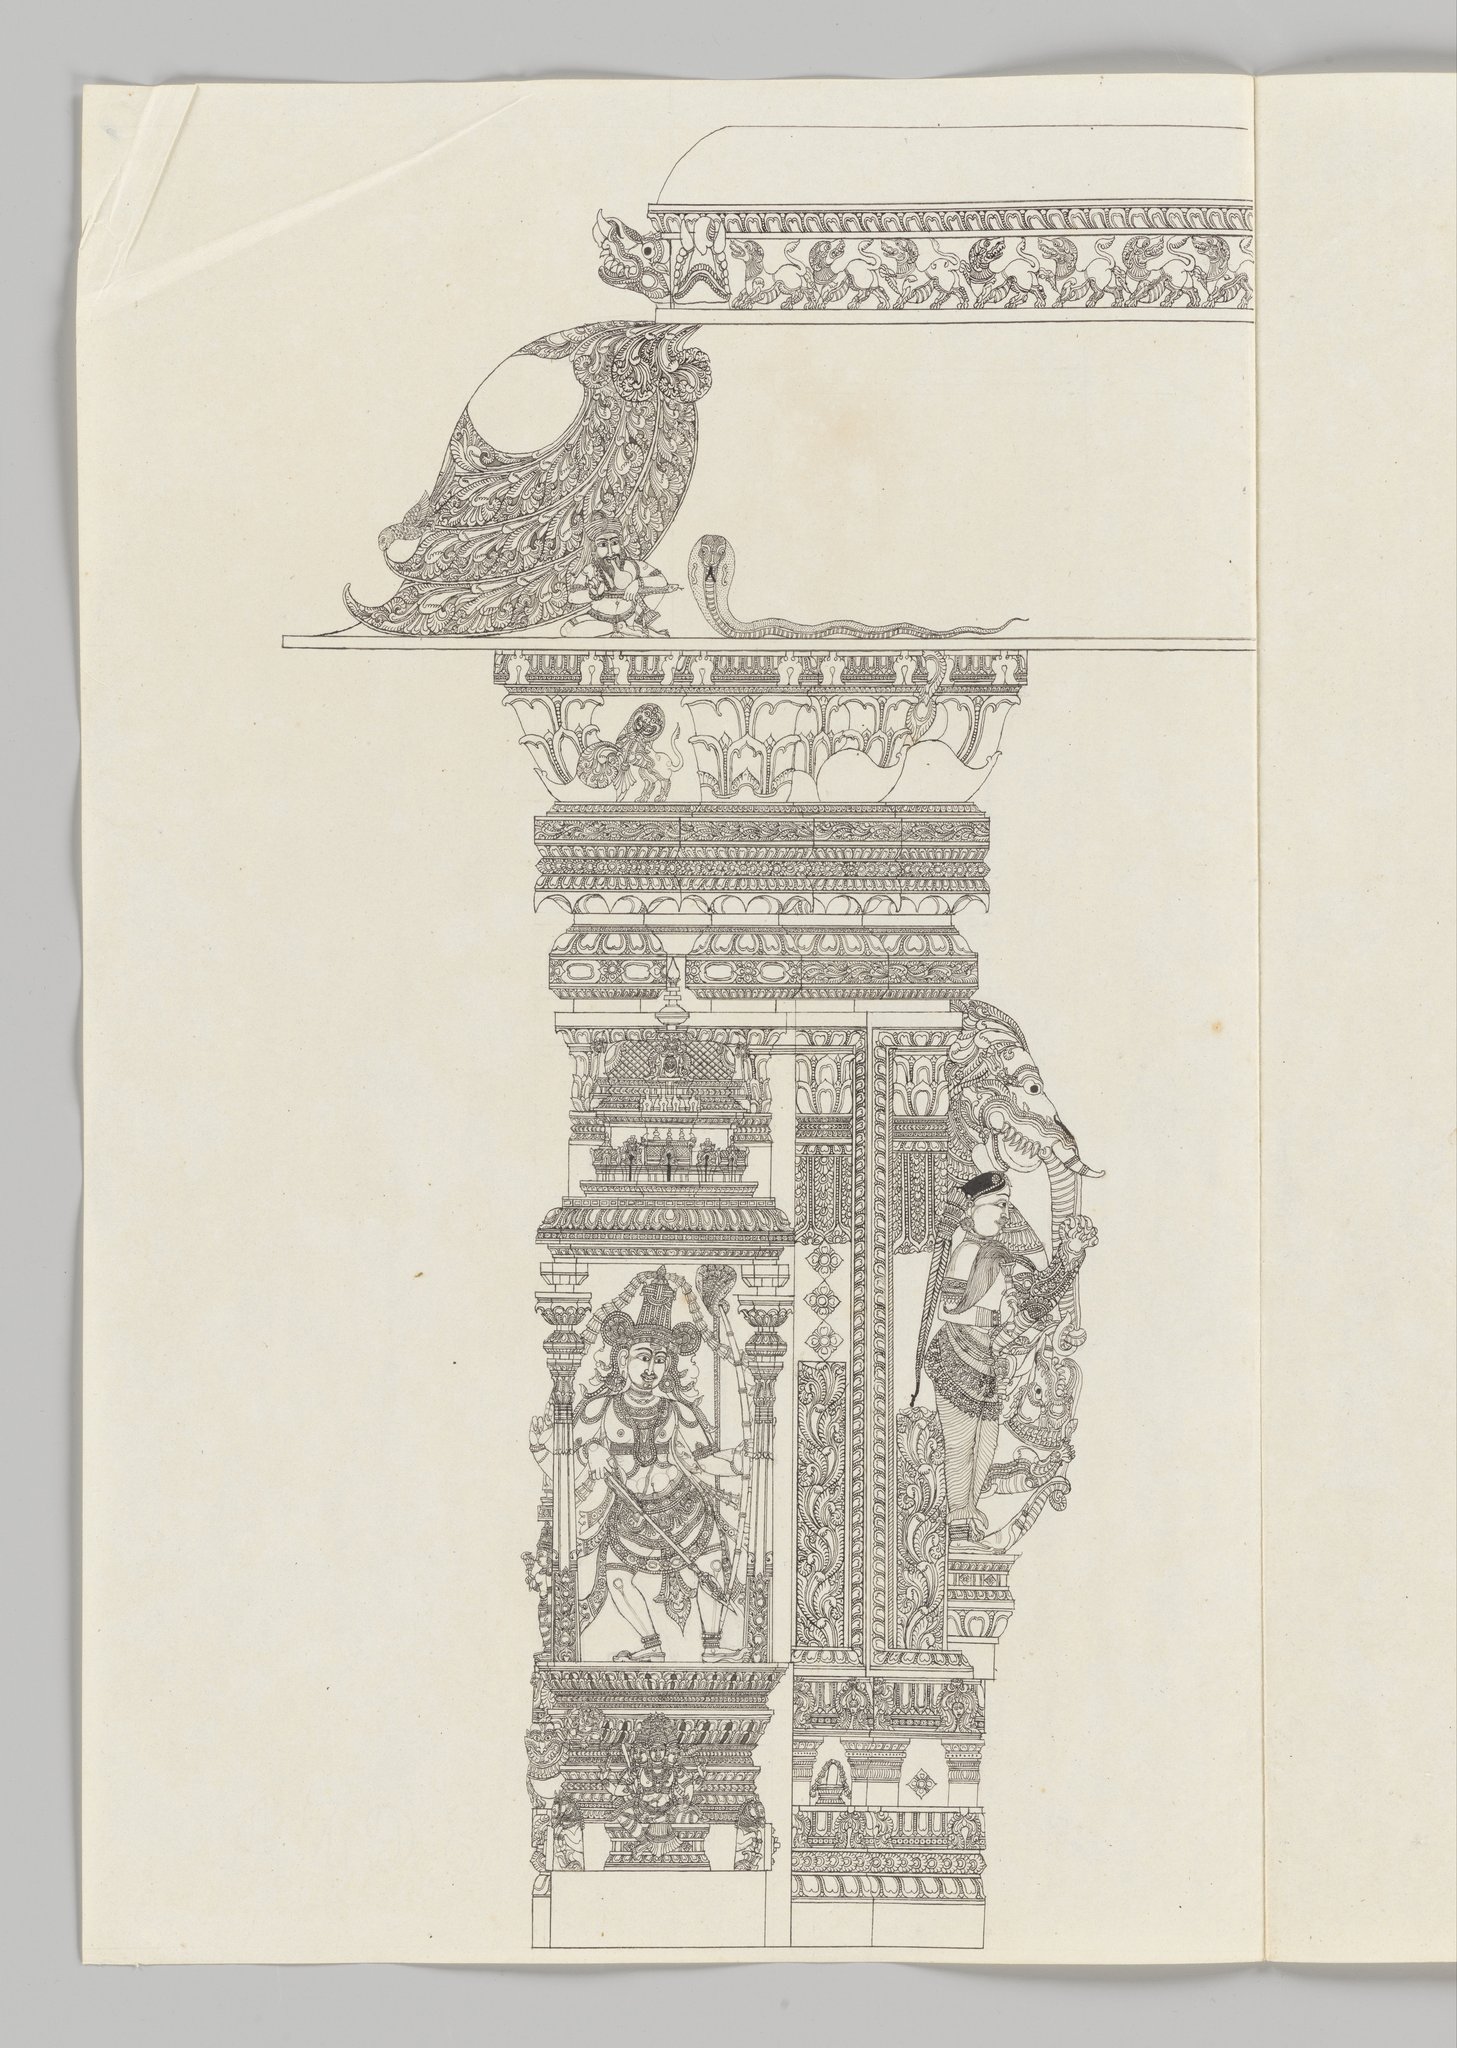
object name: drawing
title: Shiva as Tripsurasamhara; woman holding a flywhisk; rearing yali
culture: indian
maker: unidentified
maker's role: artist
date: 1800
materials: ink, paper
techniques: wash